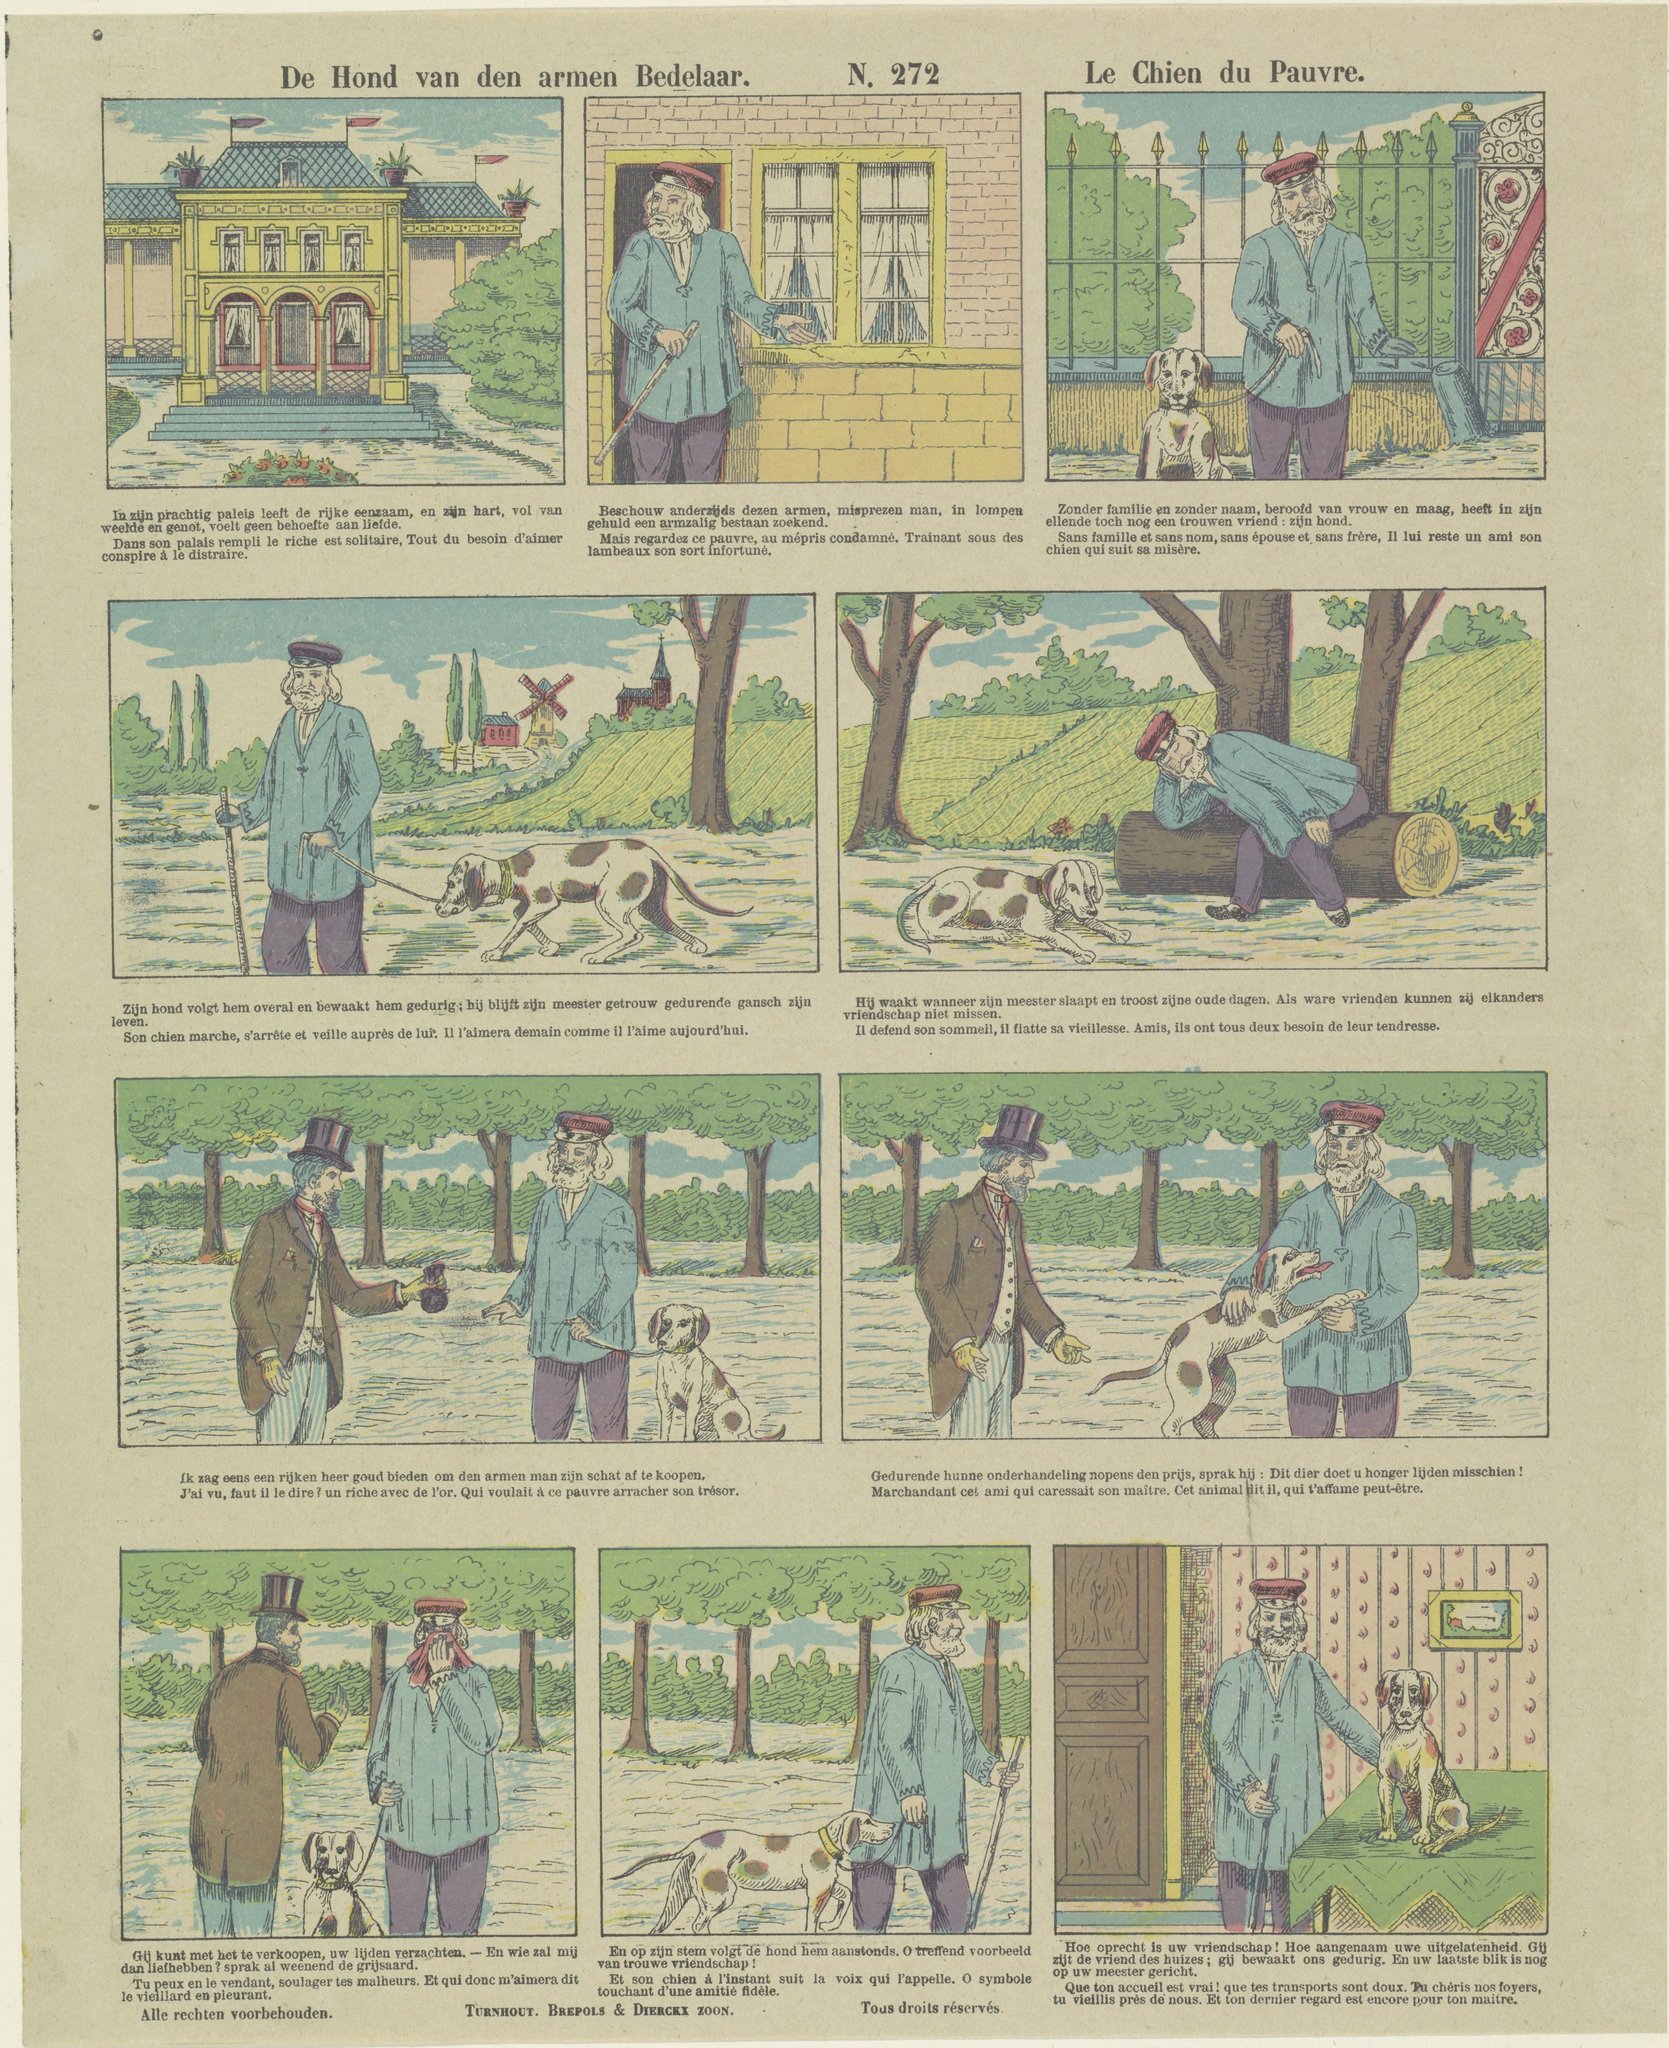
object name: print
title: Een hond van den armen bedelaar / Le chien du pauvre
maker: Anonymous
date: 1833-1911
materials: paper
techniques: lithograph, letterpress printing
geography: turnhout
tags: beggar, dog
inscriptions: collector's mark: Lugt 2760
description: Blad met 10 voorstellingen over een bedelaar en zijn trouwe hond. Onder elke afbeelding een onderschrift in het Nederlands en in het Frans. Genummerd midden boven: N. 272.